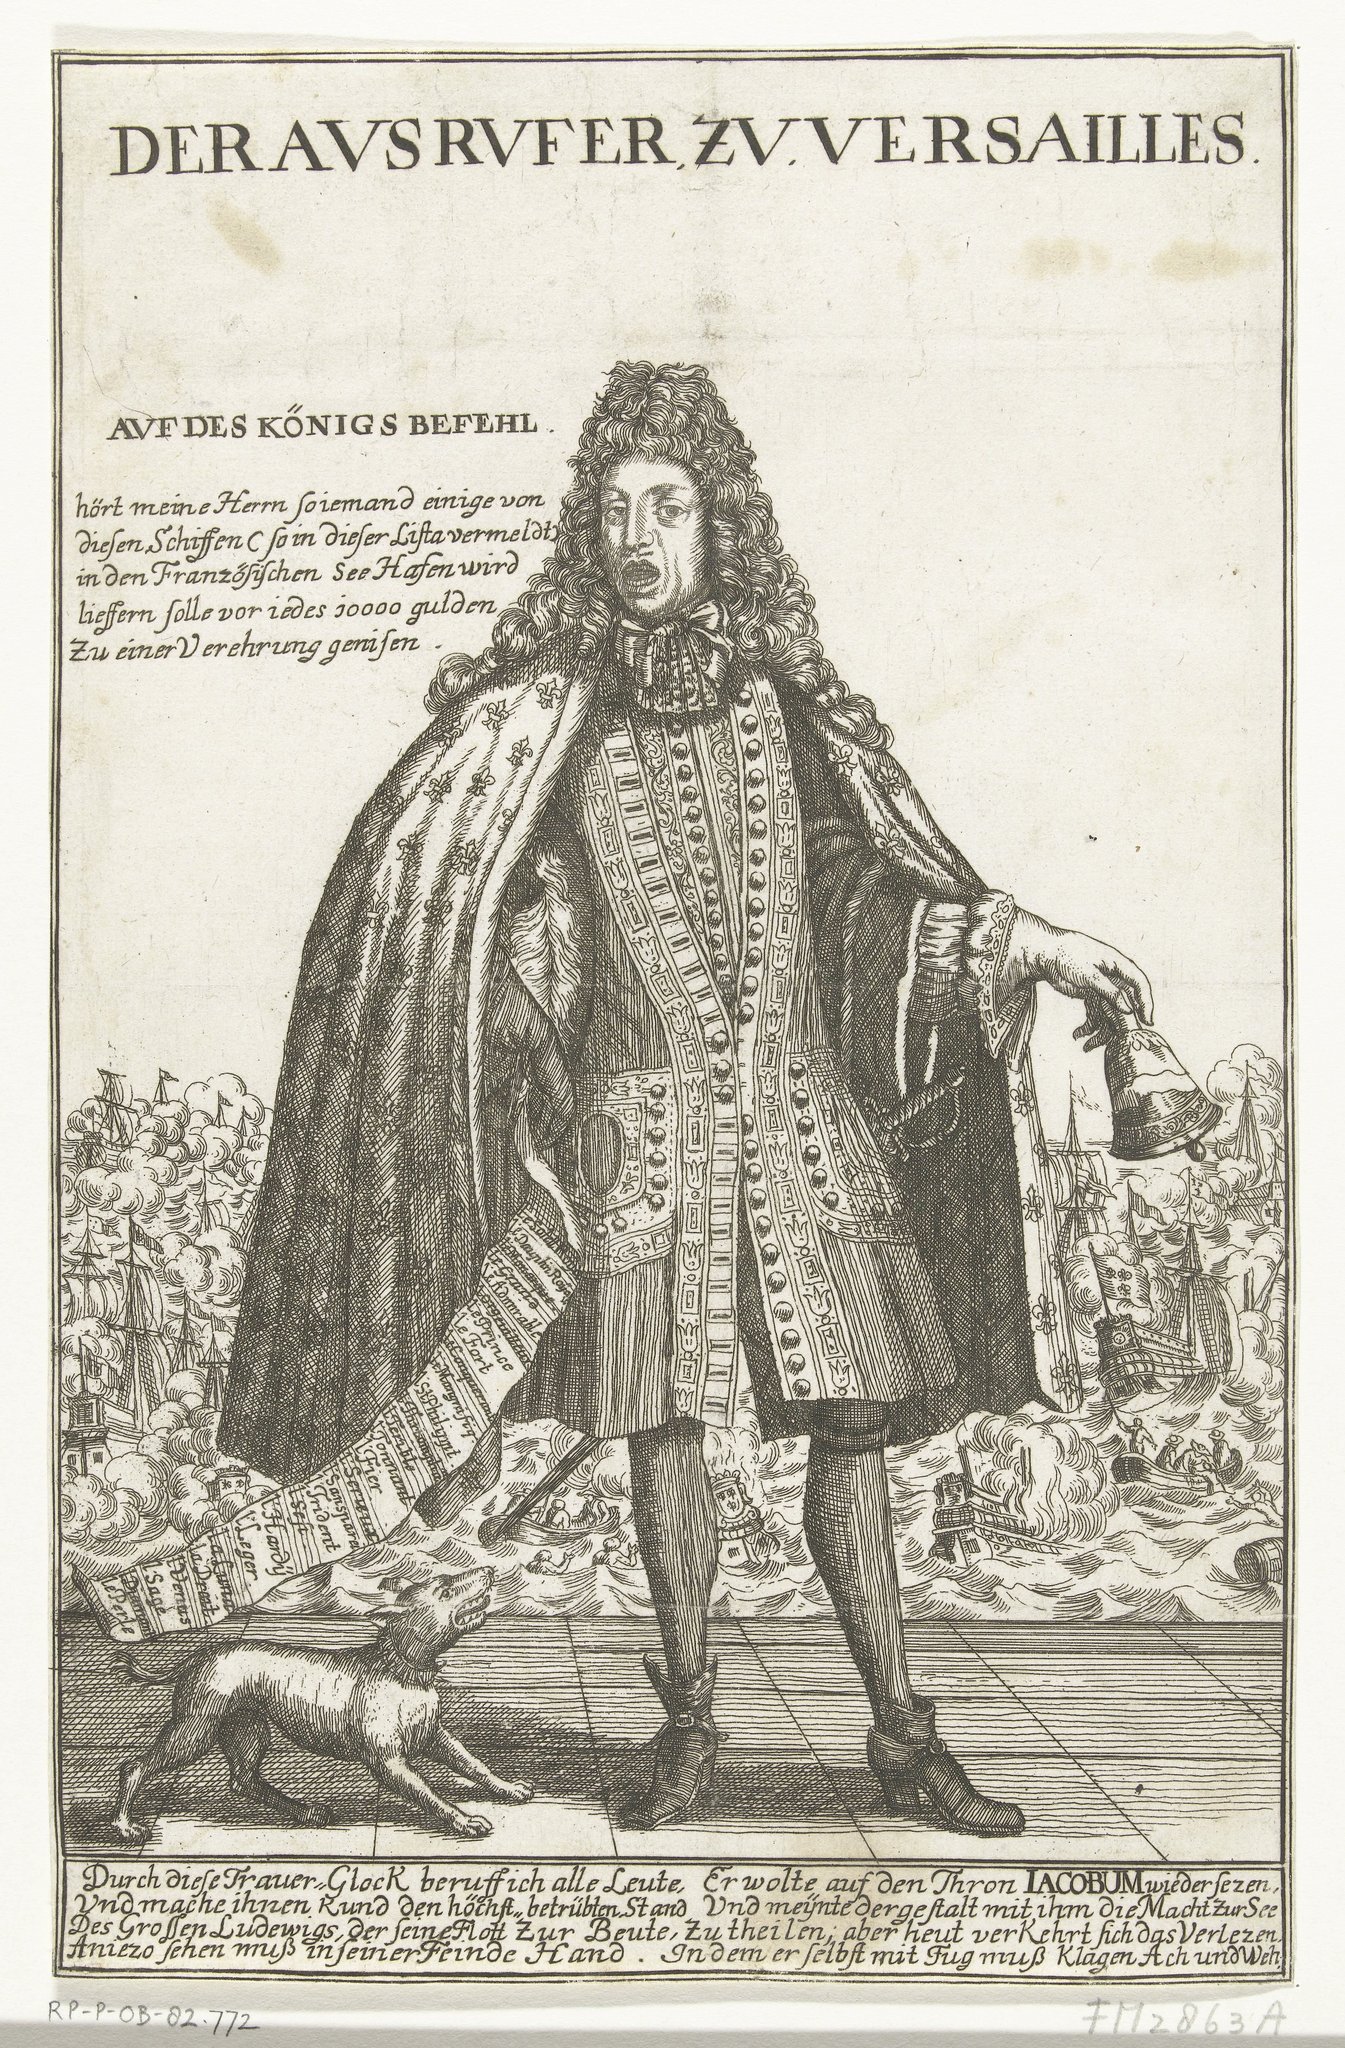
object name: cartoon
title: De Omroeper van Versailles, 1692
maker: Anonymous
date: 1692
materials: paper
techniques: etching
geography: germany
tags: lodewijk xiv (koning van frankrijk), paris, battle (+ naval force), oral spreading of news, town crier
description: De Omroeper van Versailles. Spotprent op de Franse koning Lodewijk XIV die als een stadsomroeper het nieuws brengt van de nederlaag in de zeeslag bij Kaap la Hogue waarbij de Fransen onder admiraal de Tourville werden verslagen door de gecombineerde vloot van Engeland en Holland onder de admiralen Russel en Almonde, 29 mei t/m 3 juni 1692. In de linkerhand een schel, in de rechterhand een lange lijst met de namen van de verbrande Franse schepen, bij zijn voeten een blaffend hondje, op de achtergrond de zeeslag. In de voorstelling een oproep uit naam van de koning en onderaan twee verzen van vier regels in het Duits.